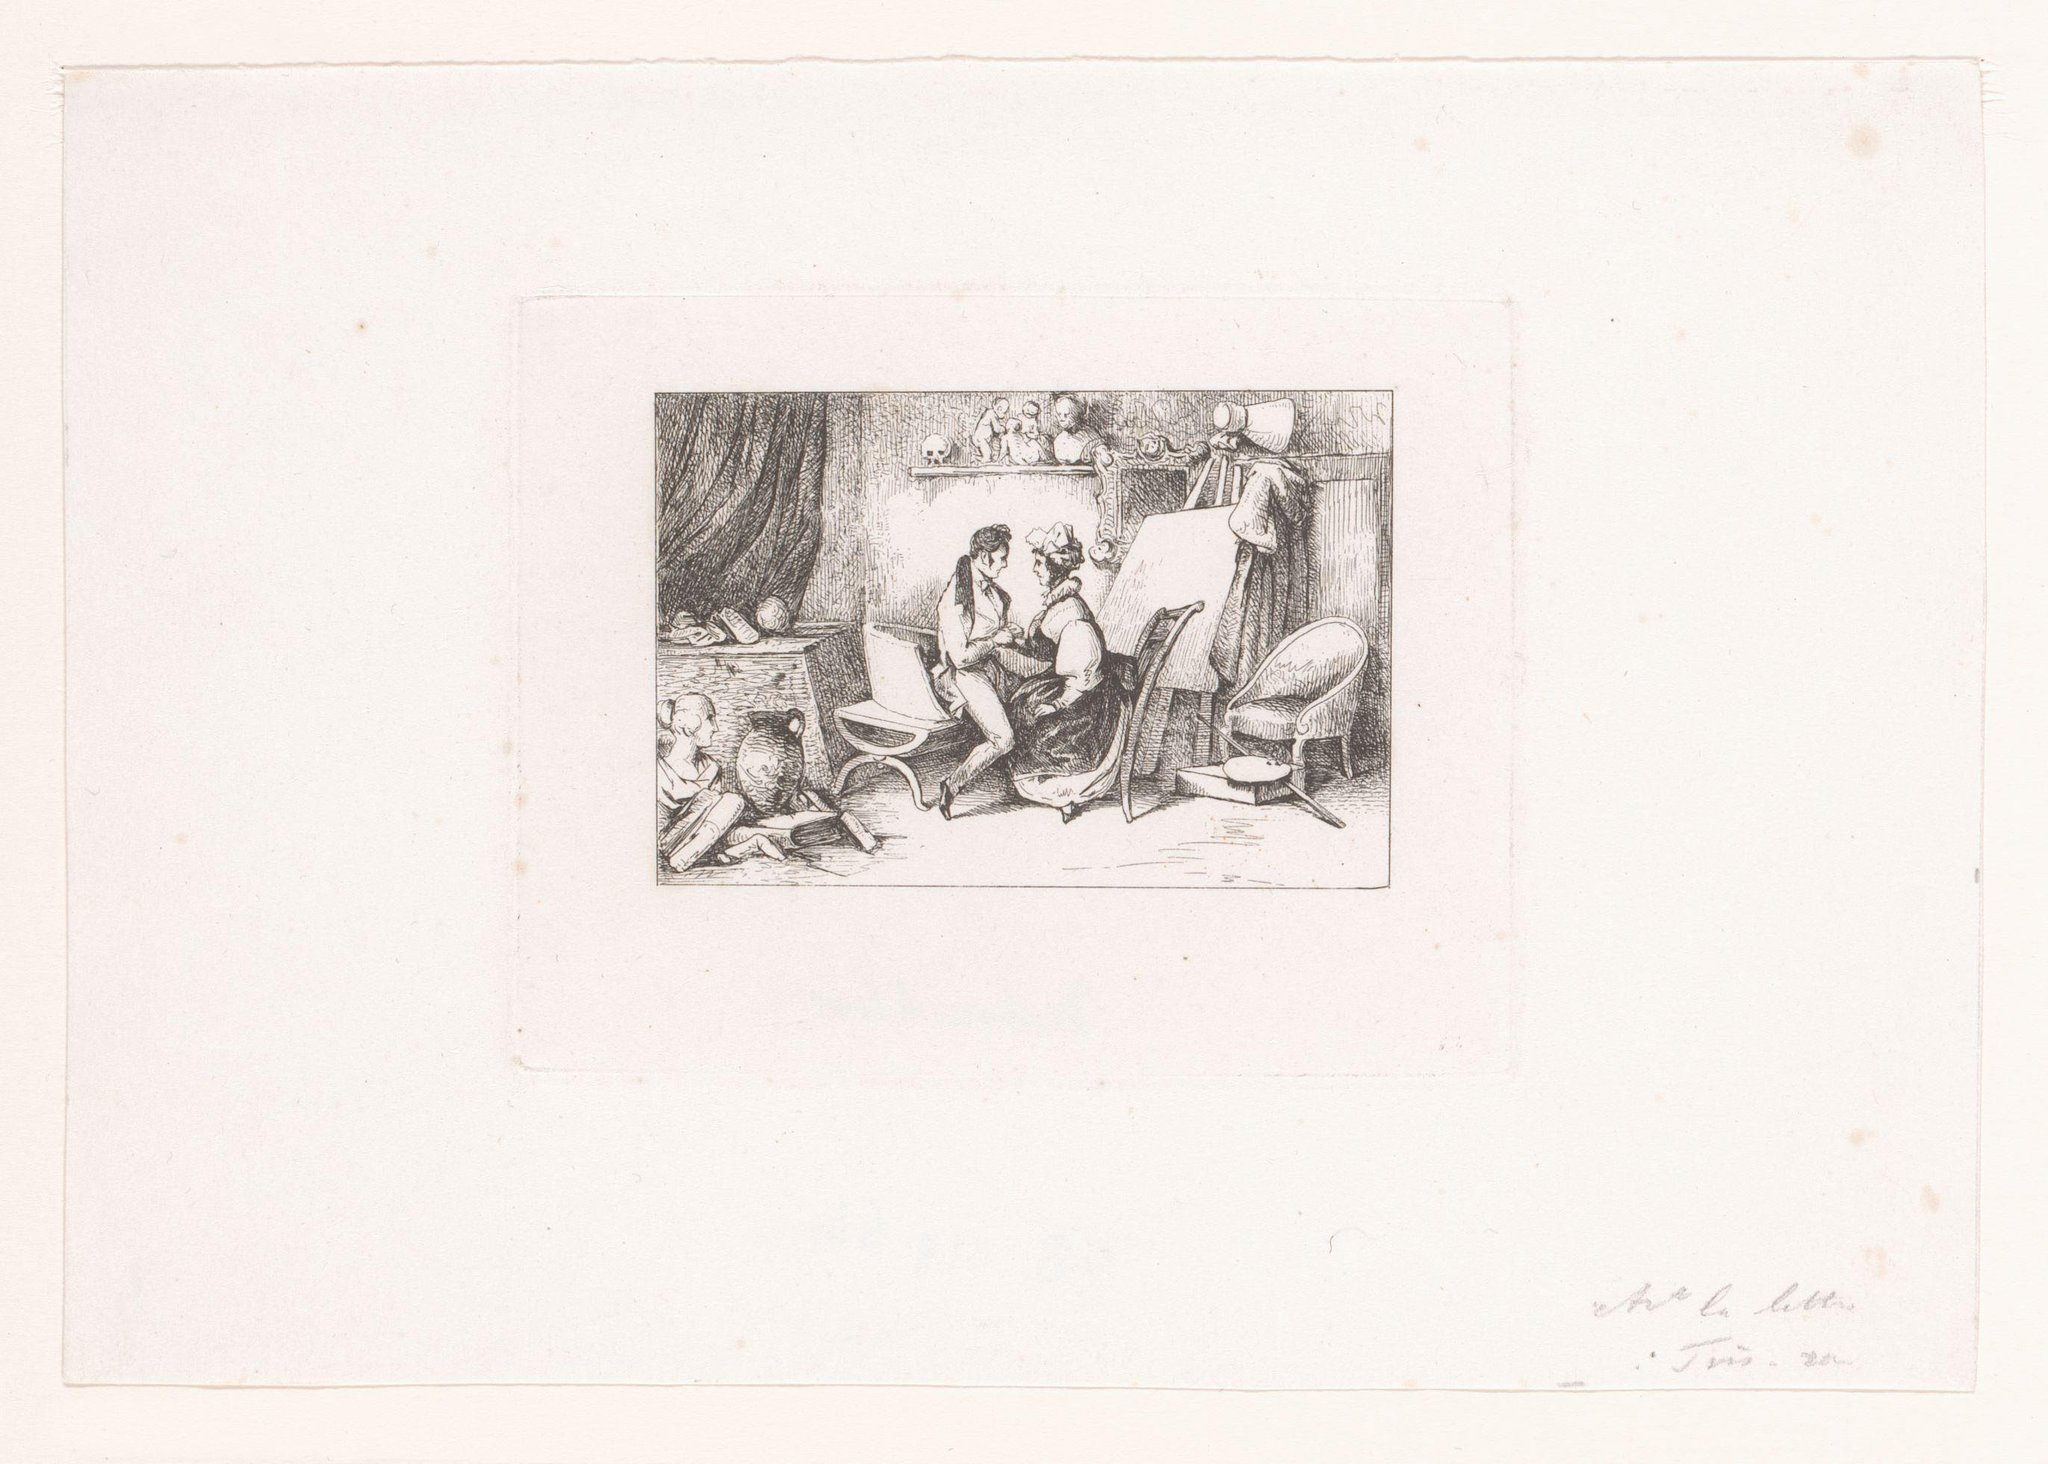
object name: print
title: Schilder en geliefde in atelier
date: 1830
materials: paper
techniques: etching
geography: paris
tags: the painter and his muse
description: Prent uit: Monnier, Henry. Scènes populaires, dessinées à la plume. Parijs: Levavasseur, 1830.